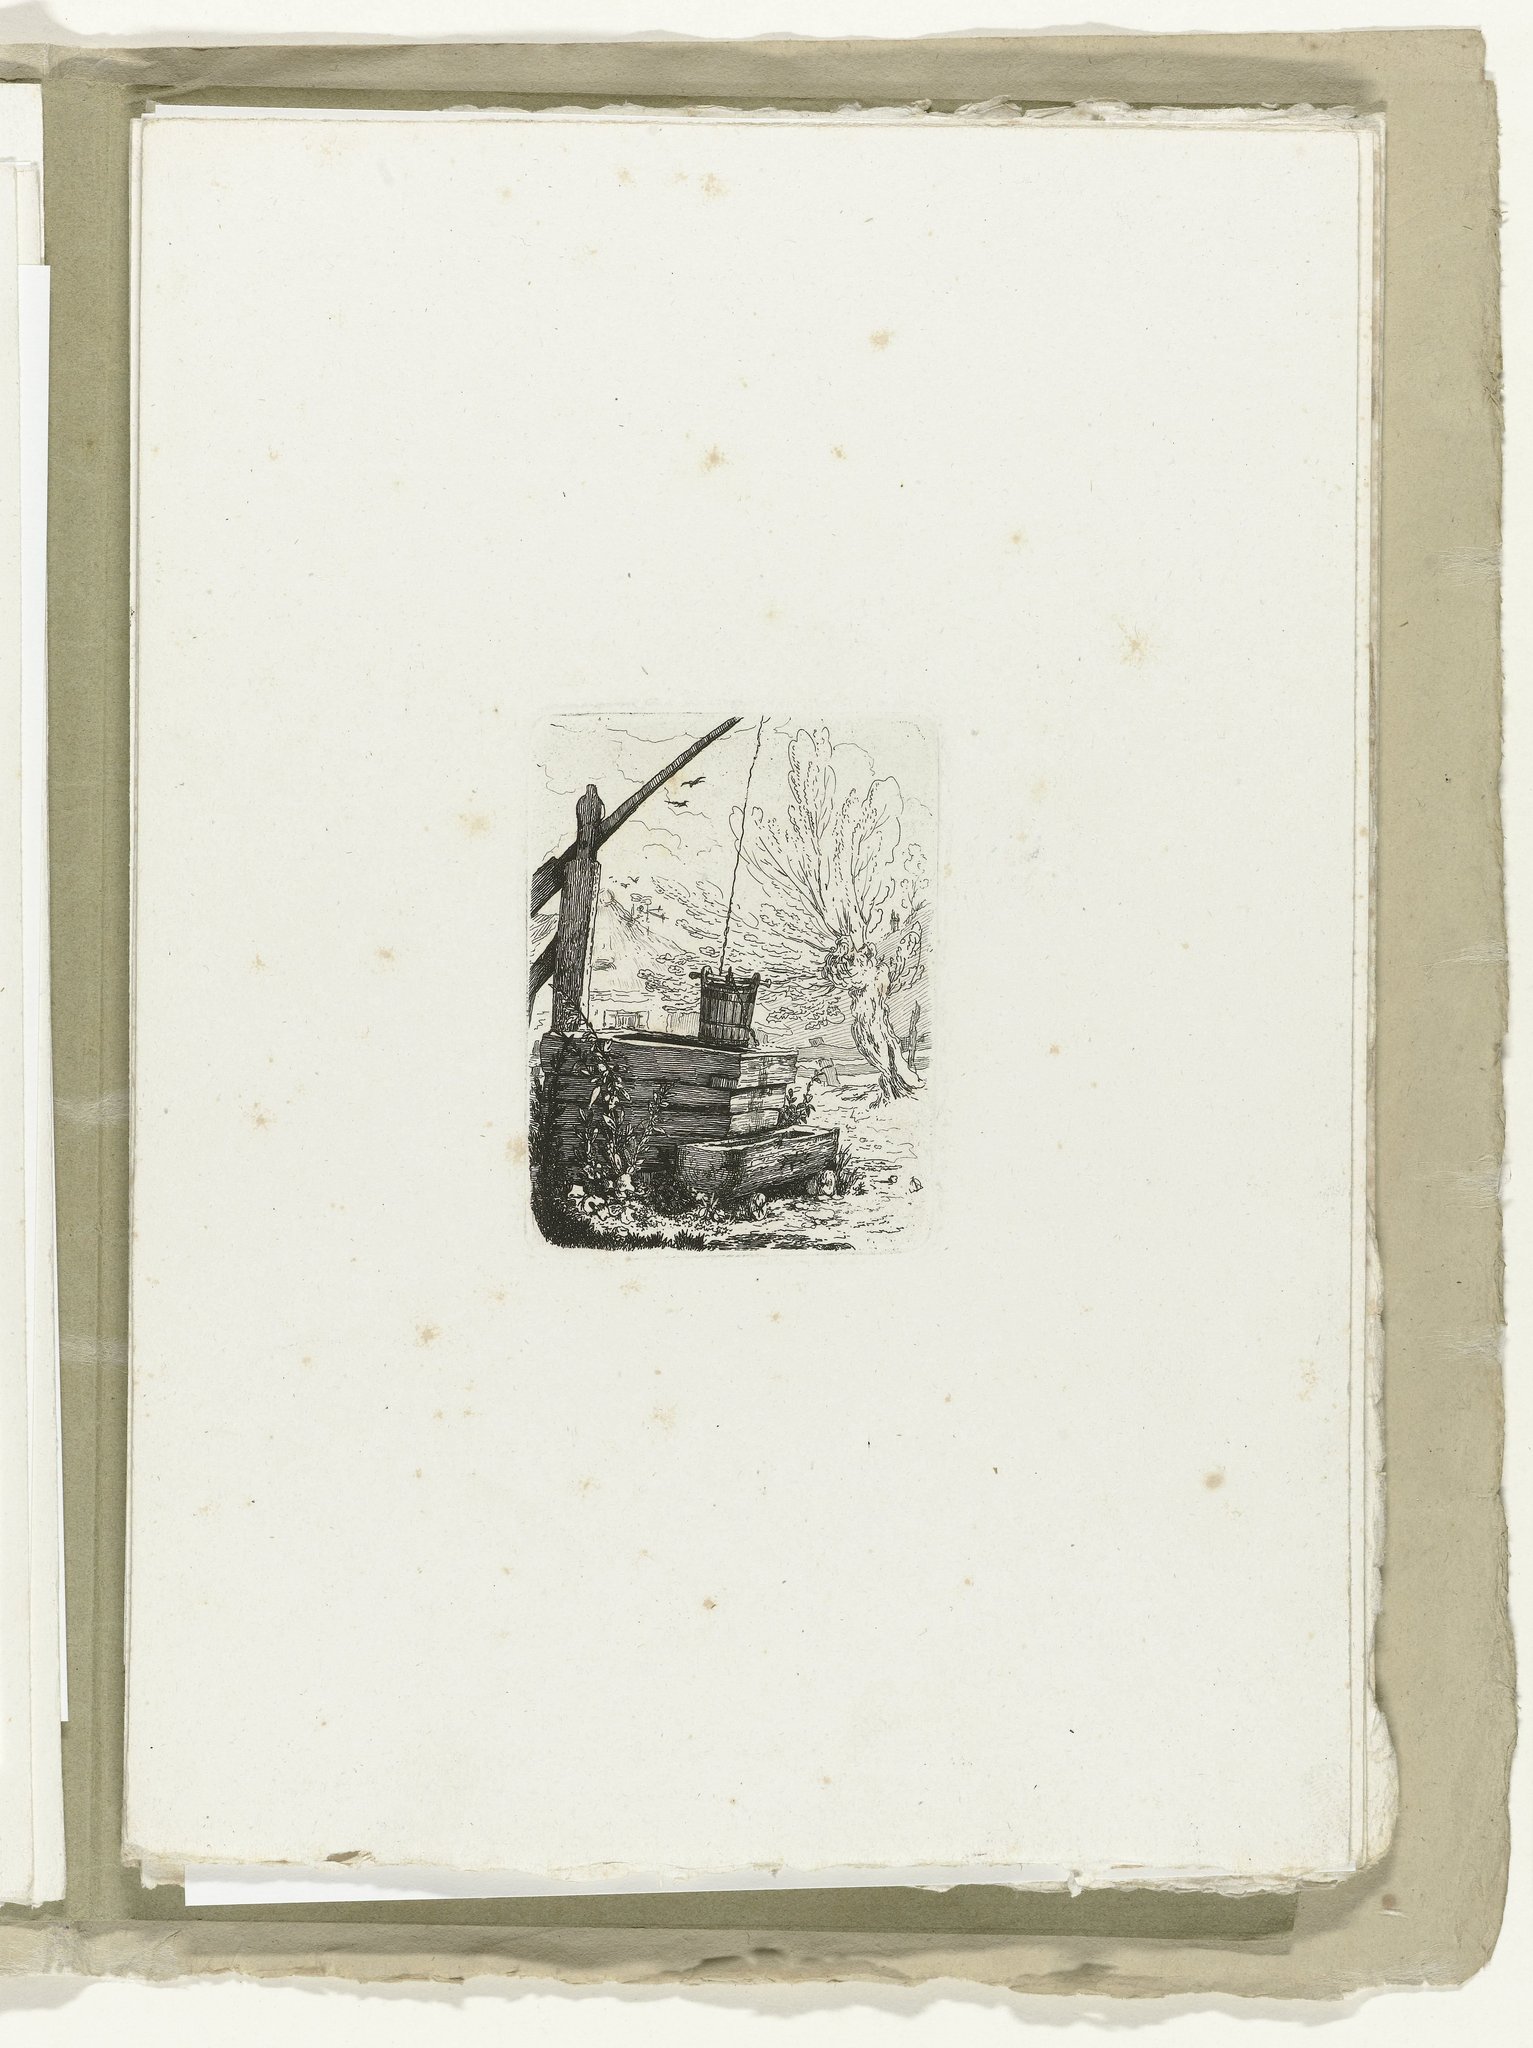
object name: print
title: Put met emmer en drinkbak voor een boerderij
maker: carl august lebschee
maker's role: draughtsman, painter, print maker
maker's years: 1800-1877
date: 1827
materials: paper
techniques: etching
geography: munich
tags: well, wooden container: barrel, cask, bucket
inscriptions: collector's mark: Lugt 2228, collector's mark: Lugt 2760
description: Deze prent maakt deel uit van een dubbel omslag.